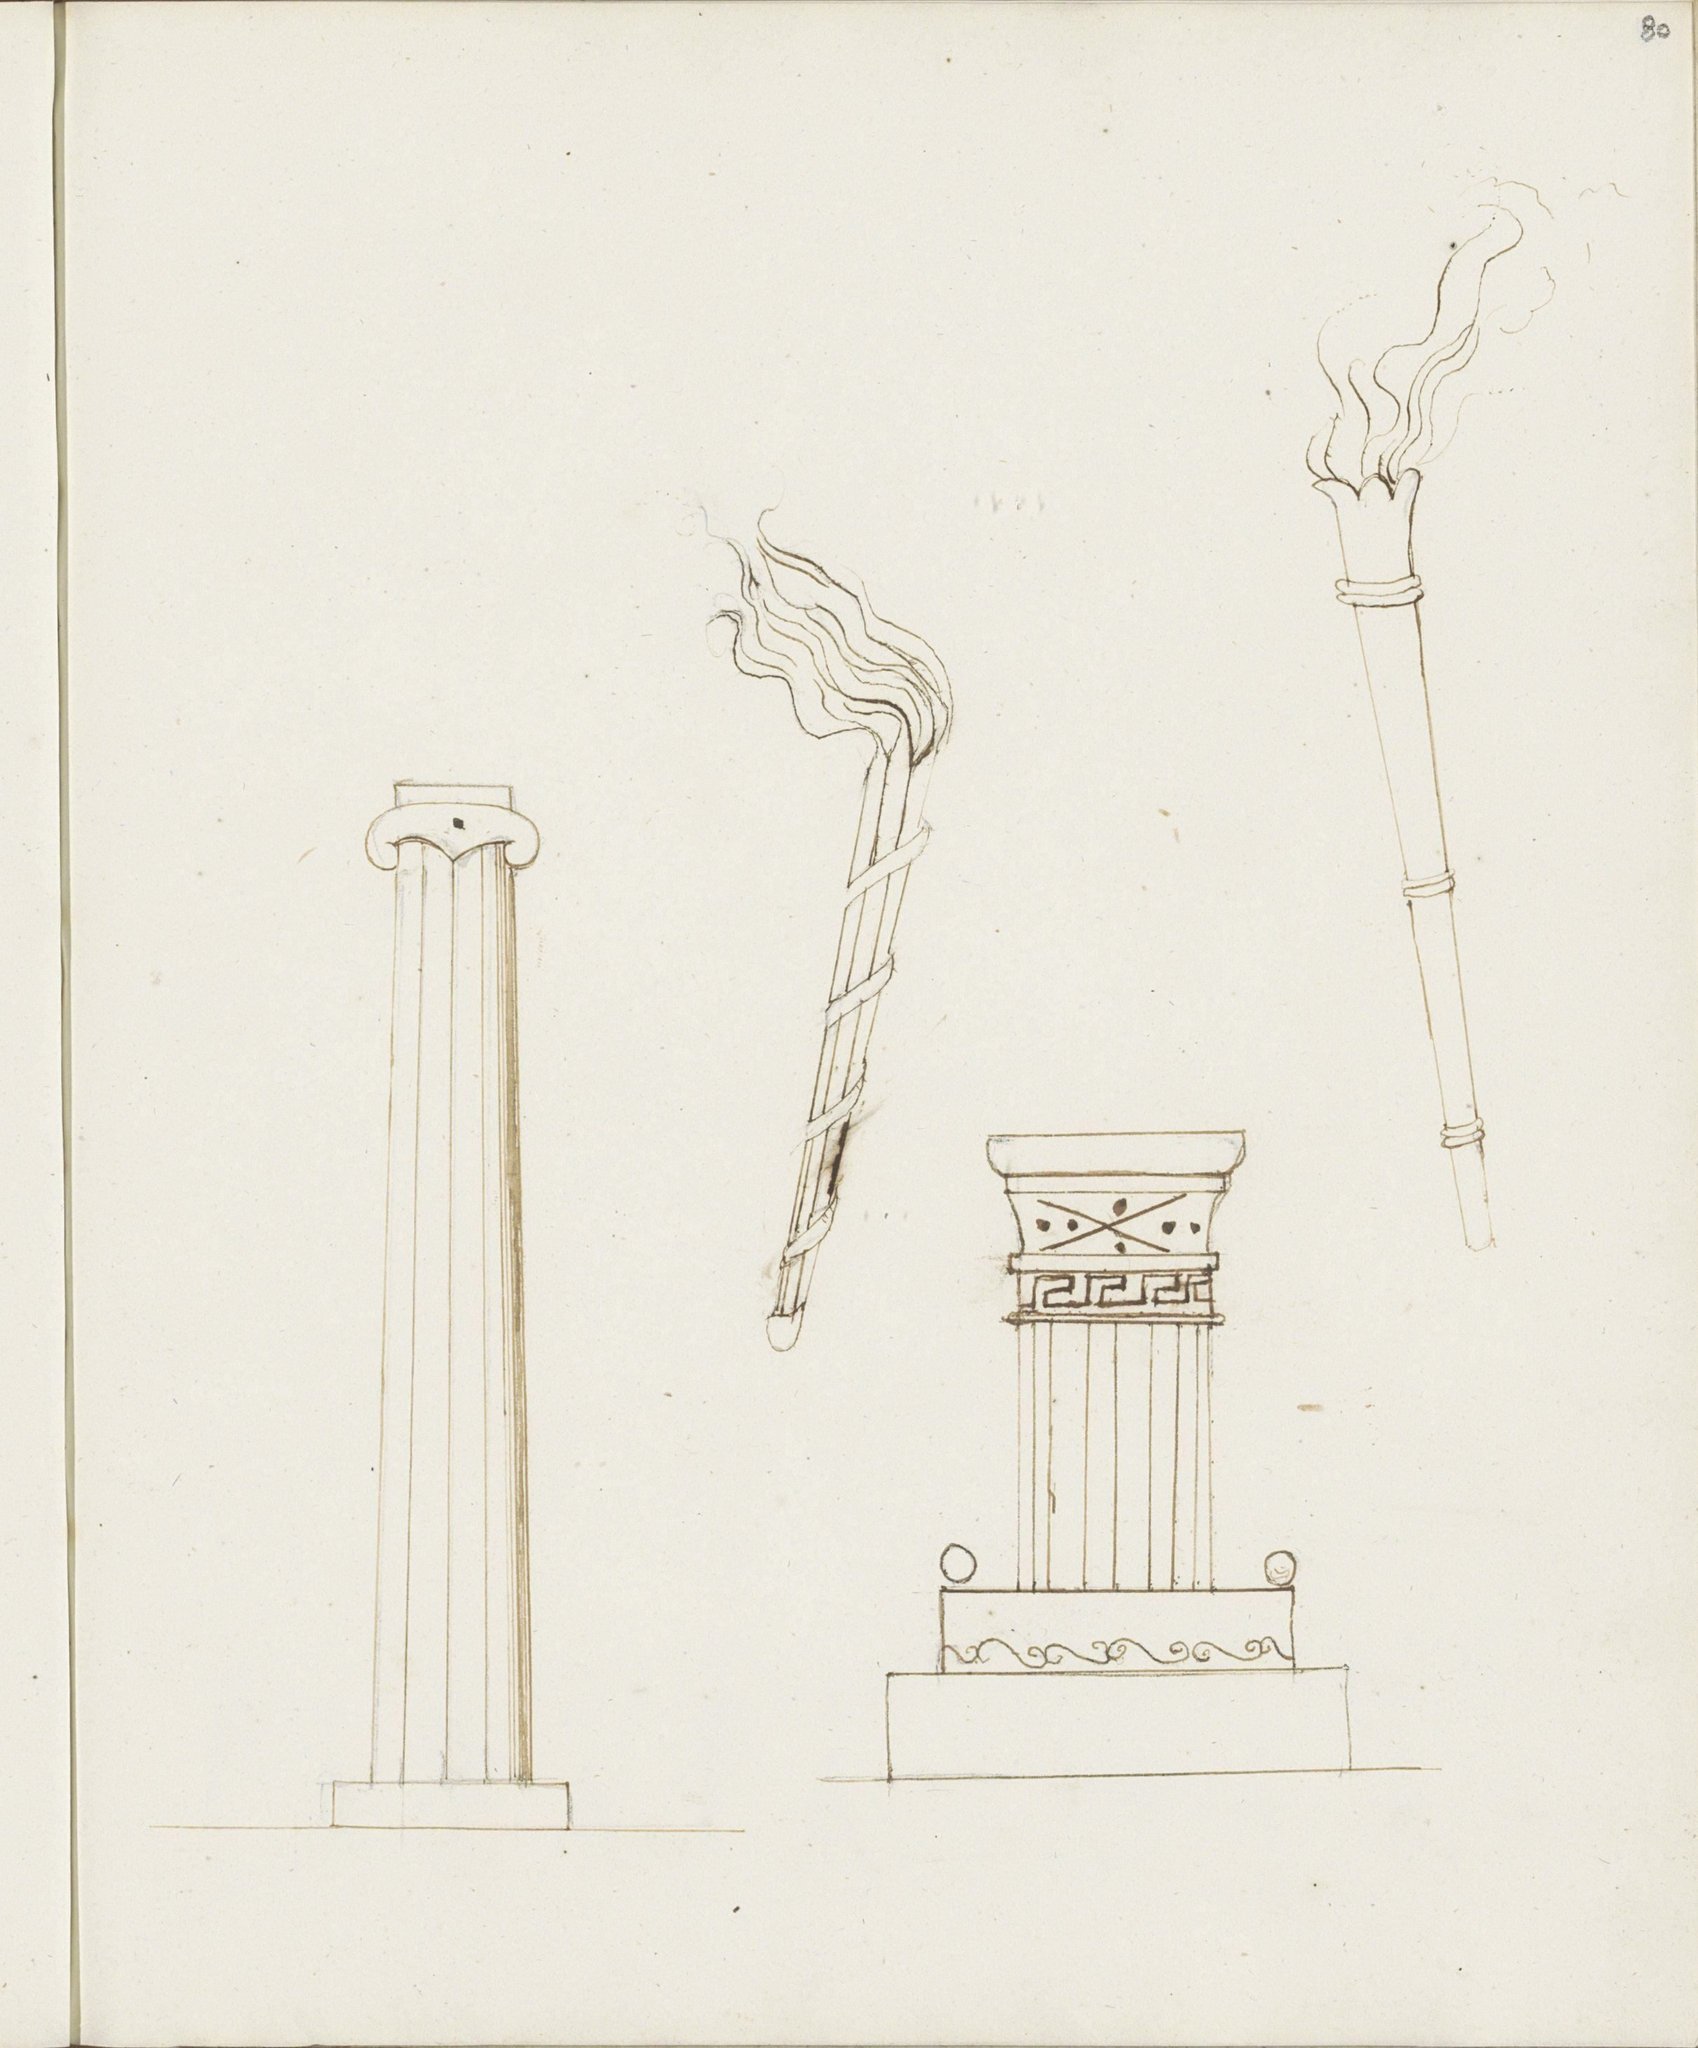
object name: sketchbook leaf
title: Ionische zuil, fakkels en een Grieks altaar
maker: jonkvrouw catharina kemper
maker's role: draughtsman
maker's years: 1801-1871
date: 1813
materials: ink, paper, pencil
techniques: pen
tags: torch, column, pillar ~ architecture, altar ~ greek religion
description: Blad 80 recto uit een schetsboek met 91 bladen.